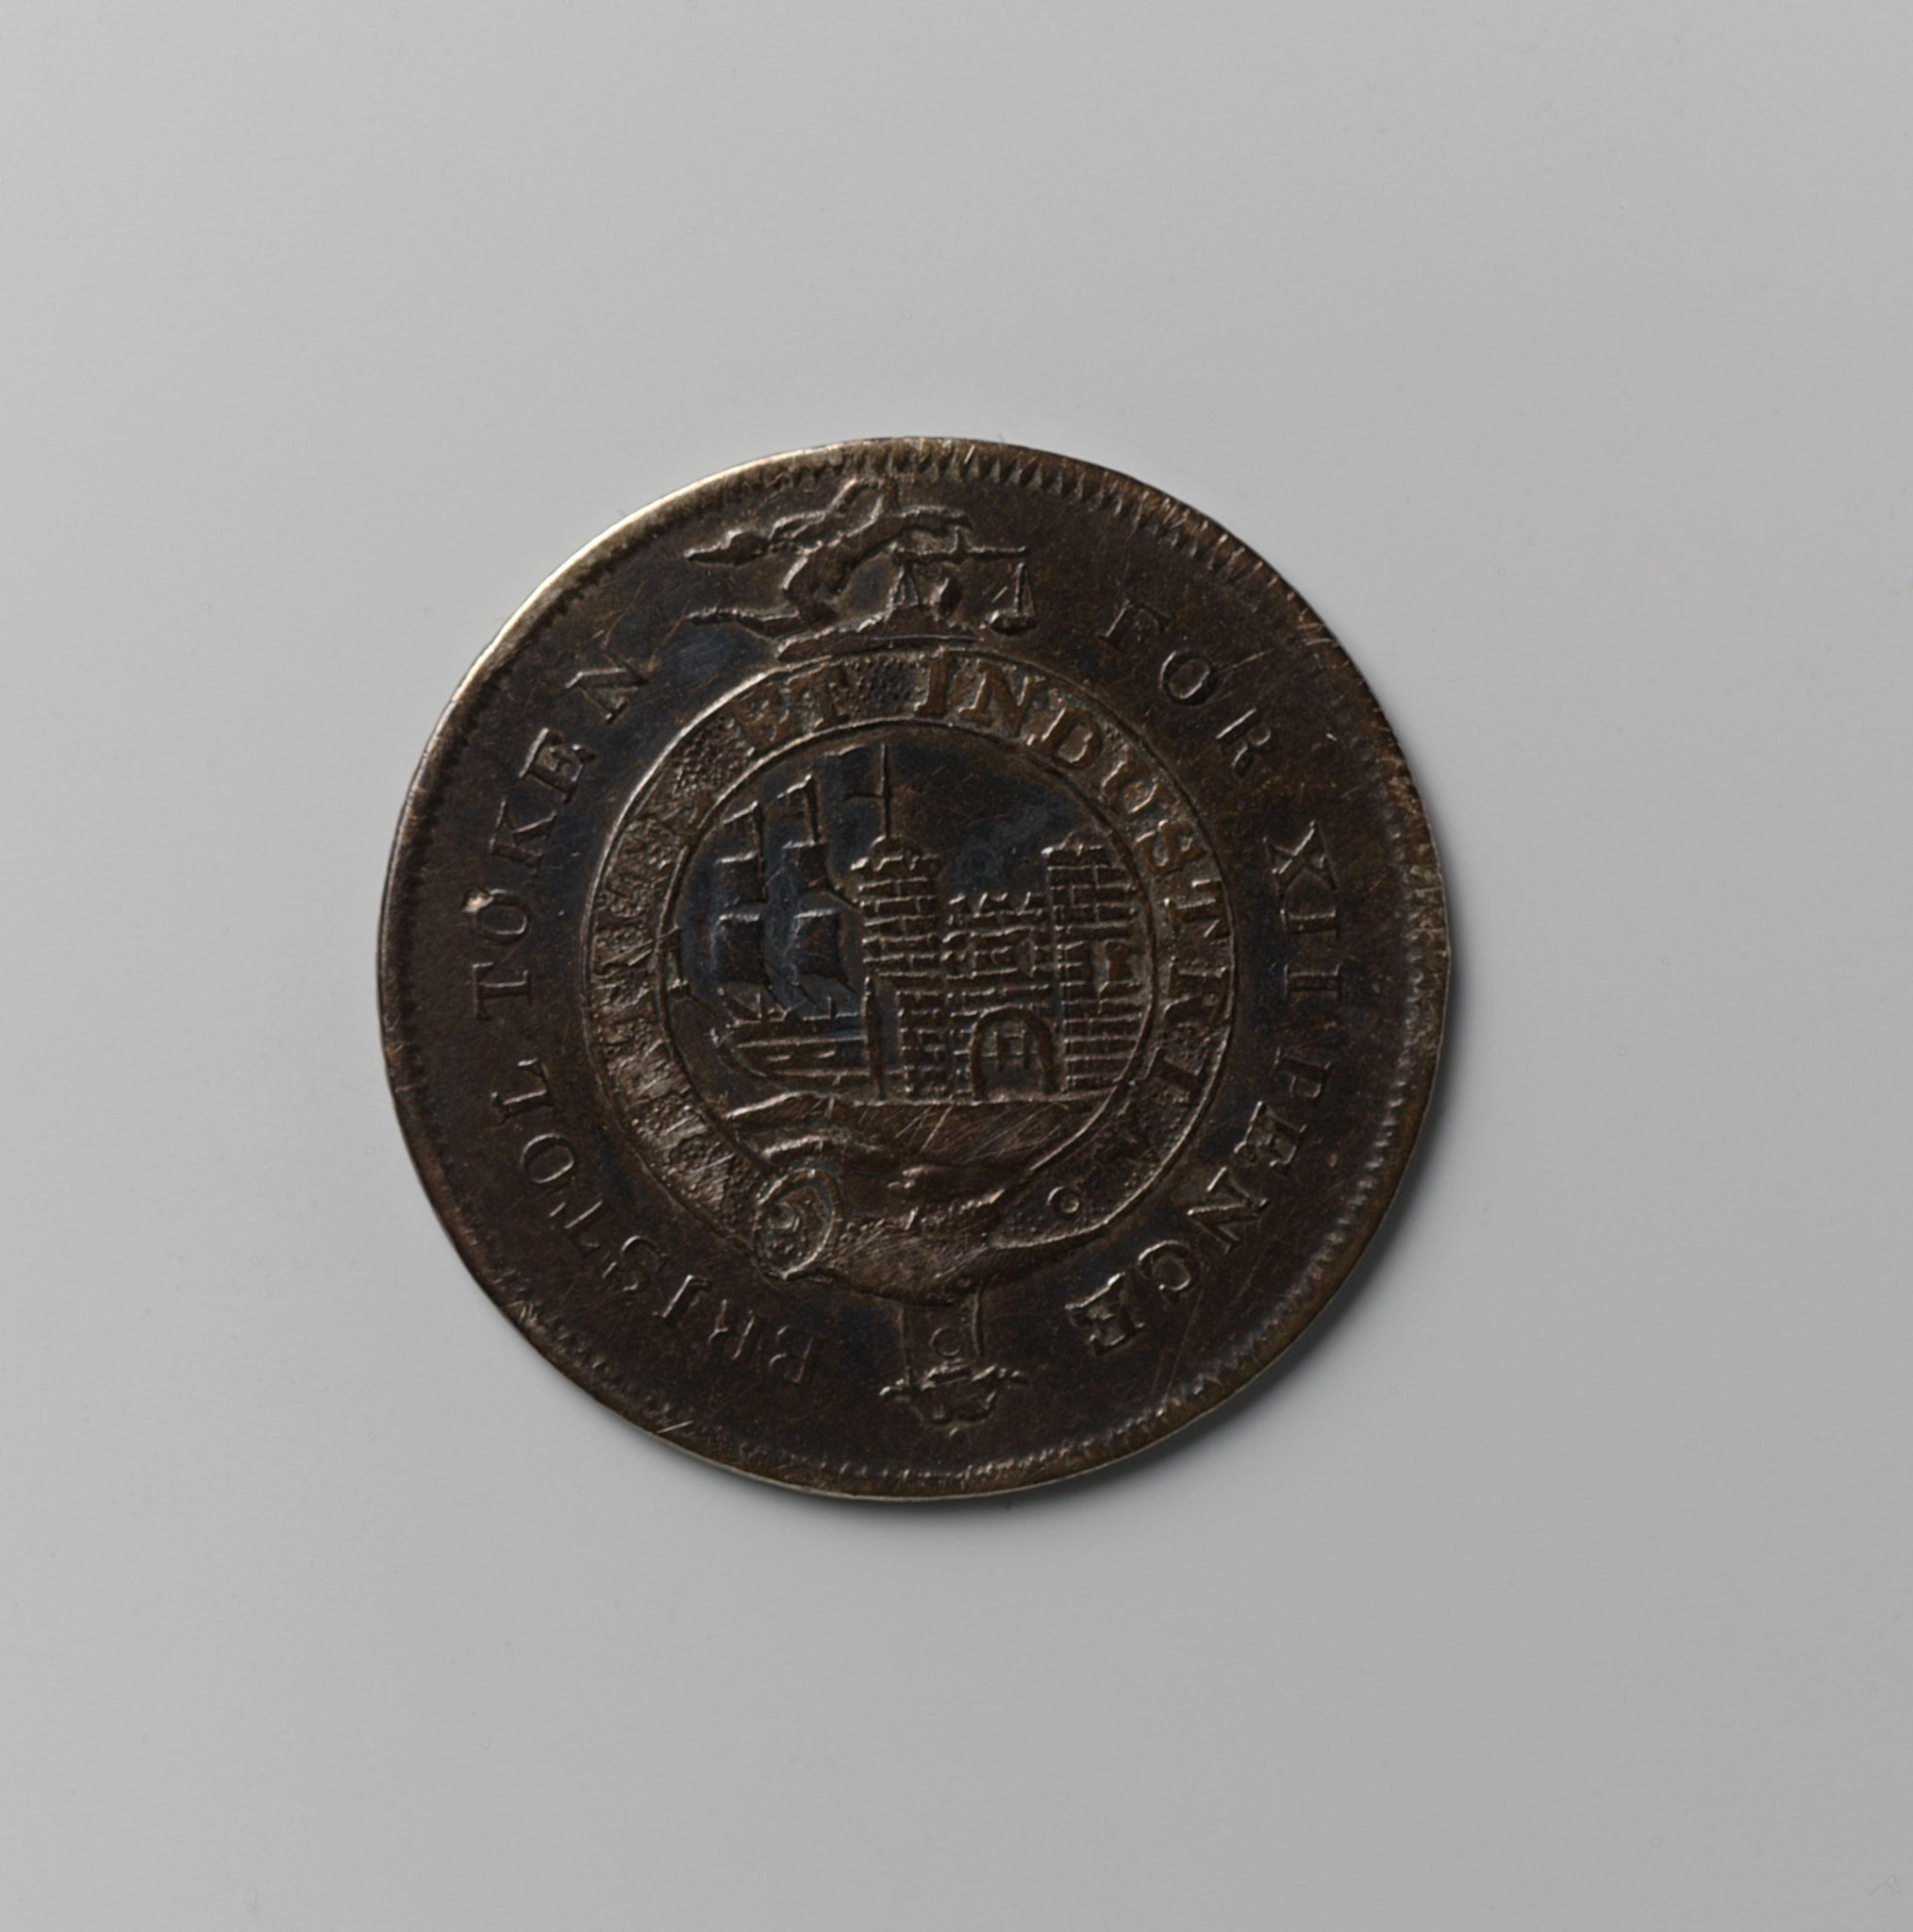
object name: monetary token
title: Token voor een shilling uit Bristol, Engeland, 1811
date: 1811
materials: copper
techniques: striking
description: Verzilverd-koperen particuliere munt. Voorzijde: binnen band met gesp, gebouw en schip. Waarde-aanduiding XII pence in omschrift. Keerzijde: zeven regelig opschrift. Kabelrand.